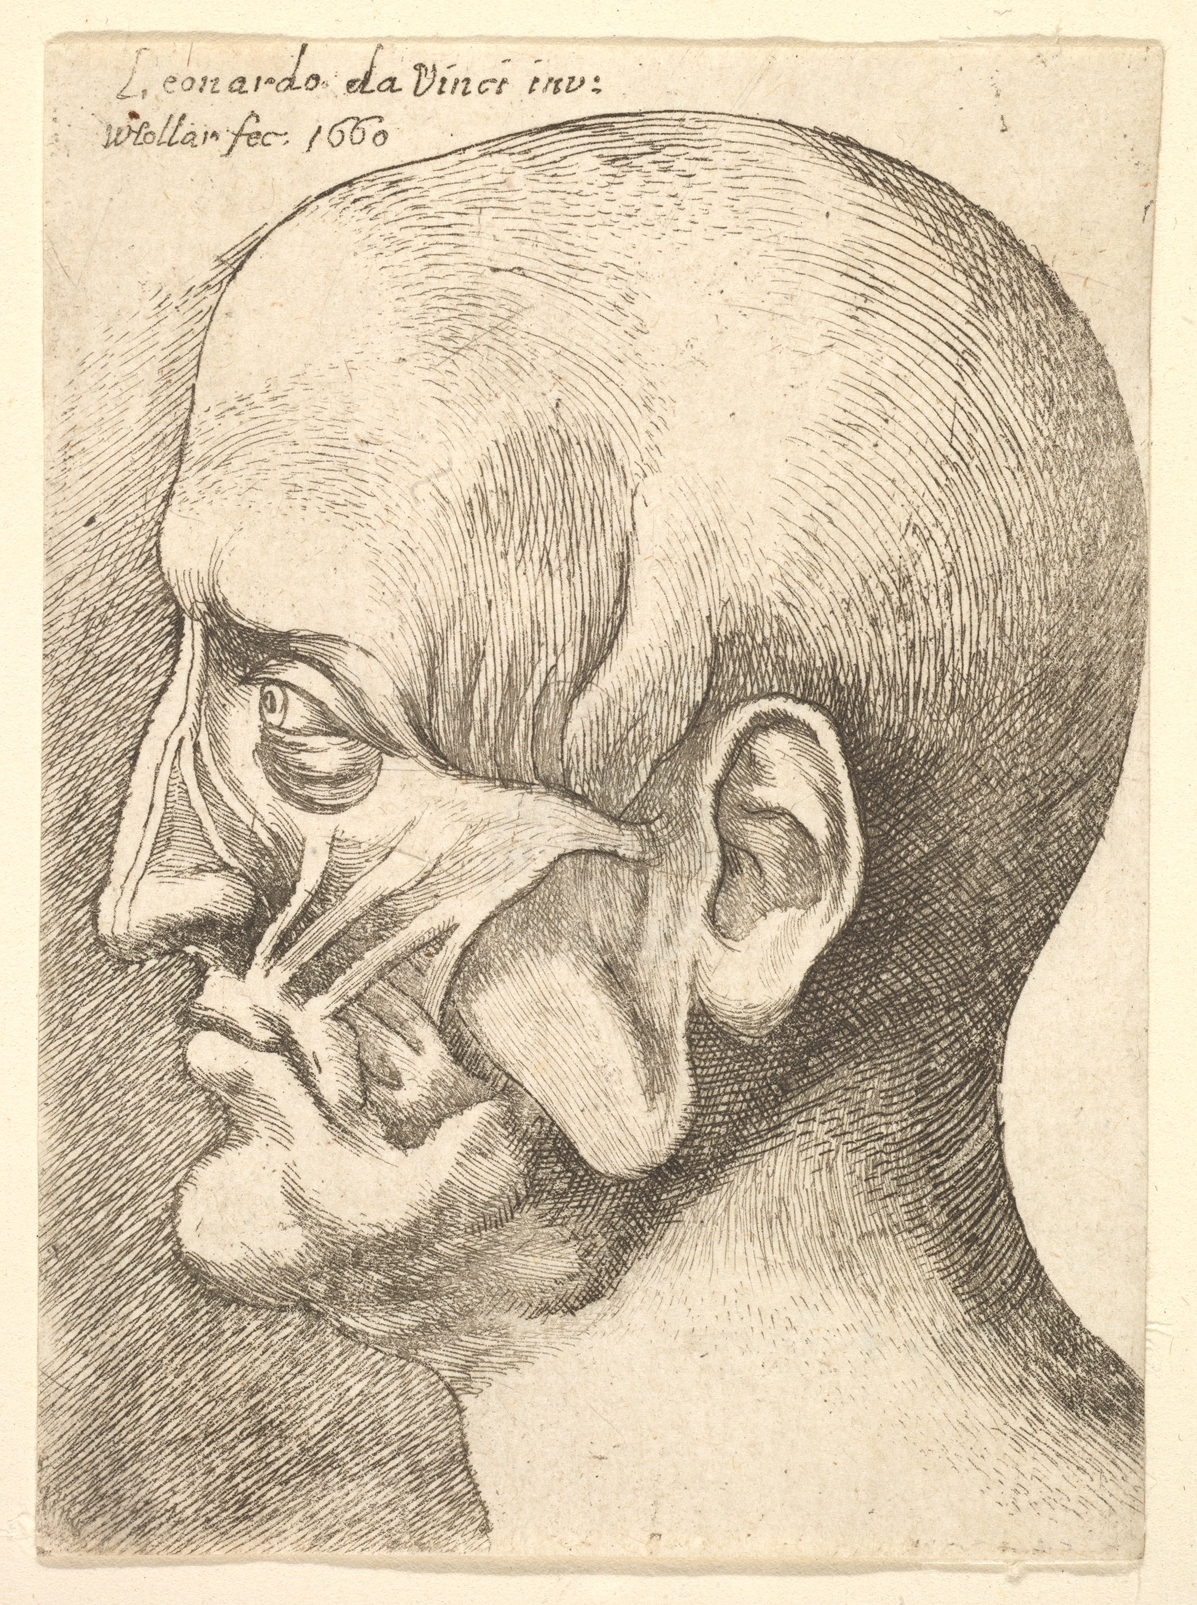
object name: print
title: Ecorche head of a man in profile to left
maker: wenceslaus hollar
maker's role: artist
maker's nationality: bohemian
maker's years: 1607-1677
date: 1660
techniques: etching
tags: human anatomy,heads,men